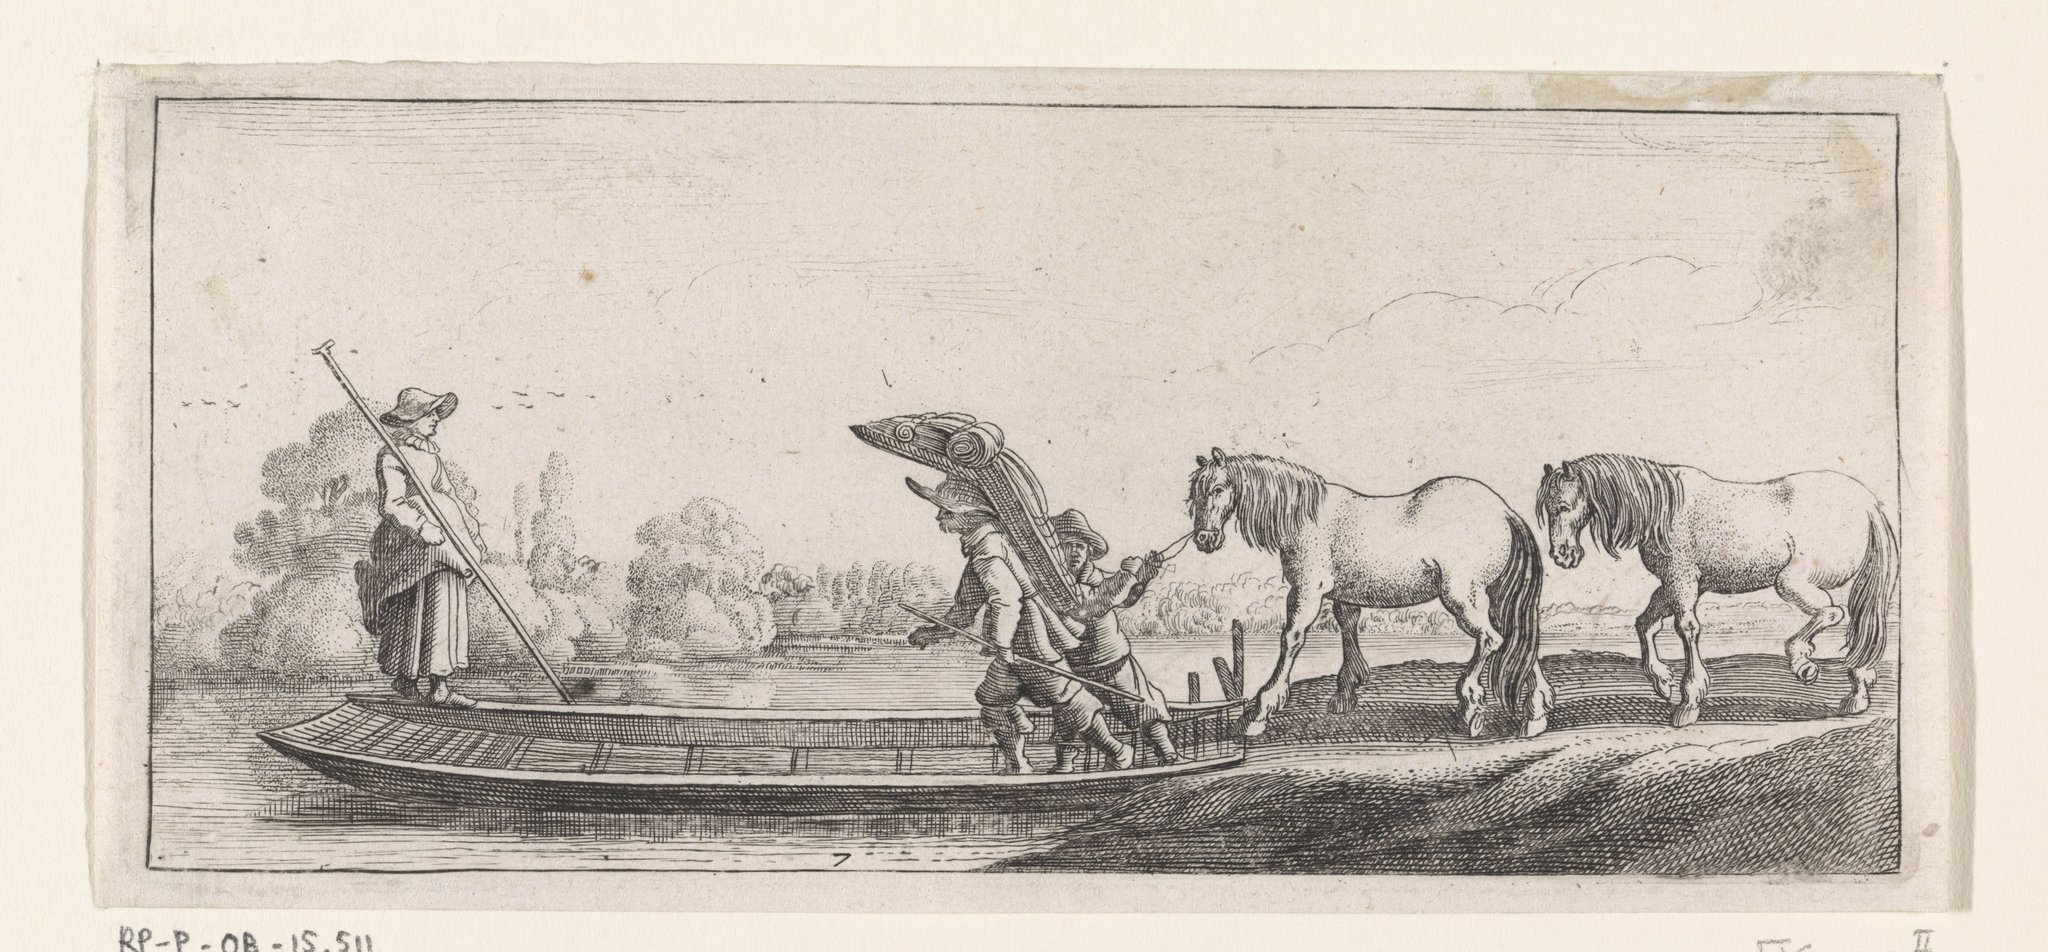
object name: print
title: Figuren in landschappen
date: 1627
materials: paper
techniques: engraving, etching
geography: northern netherlands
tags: pedlar, ferry, horse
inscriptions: collector's mark: Lugt 240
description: Prent ook gebruikt als boekillustratie in: Campanus, M., Colevelt, J.J. Craen, A.P., Robbertzen, J. Amsterdamsche Pegasus, waer in (uyt lust) byeen vergadert zijn veel minnelycke liedekens. Amsterdam: Cornelis Willemsz Blaeu-laken, 1627.